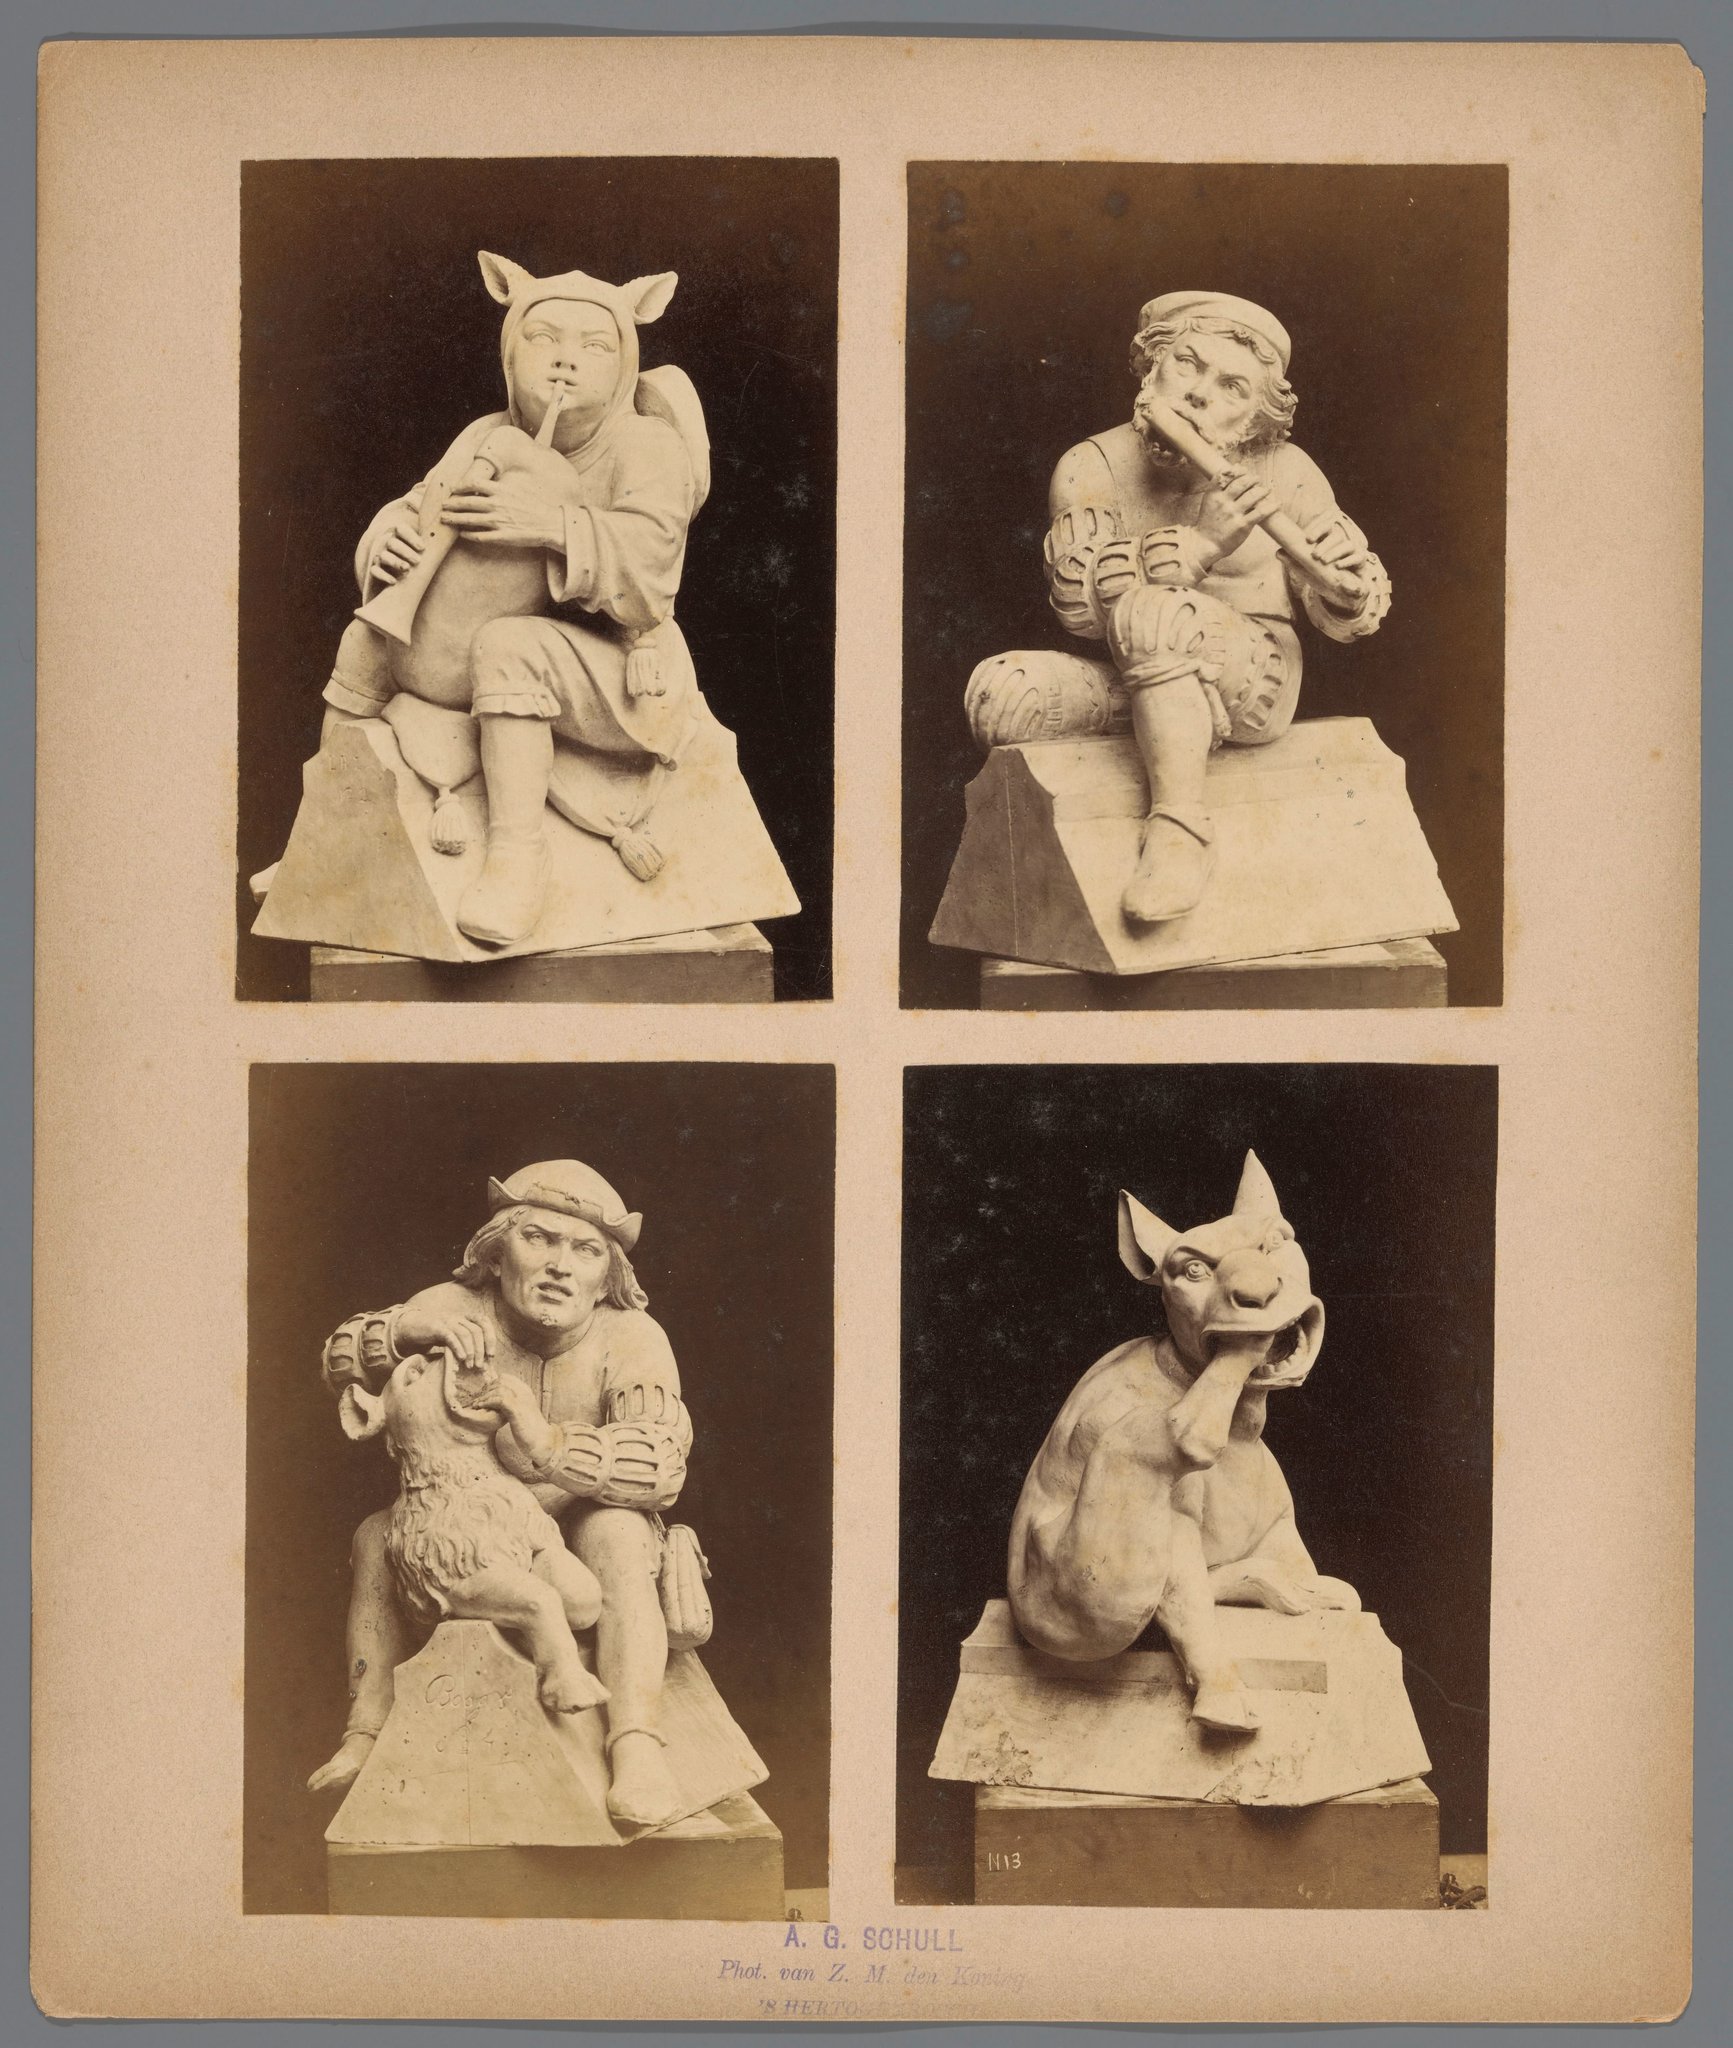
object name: photograph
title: Overzicht van vier luchtboogfiguren van de Sint-Janskathedraal te 's-Hertogenbosch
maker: antonius godefridus schull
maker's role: fotograaf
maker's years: 1819-1896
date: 1875-1900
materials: cardboard, photographic support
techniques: albumen print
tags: musician at work, sculpture, beasts of prey, predatory animals: lion, dog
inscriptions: name: ‘S. FRANCO, b.i. den Haag.’, name: ‘A. G. SCHULL Phot. van Z. M. den Koning 'S HERTOGENBOSCH’, number: ‘N13’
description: Linksboven een figuur die doedelzak speelt, rechtsboven een fluitspelende man, linksonder een man die de muil van een leeuw opentrekt en rechtsonder een hond die op zijn poot bijt.